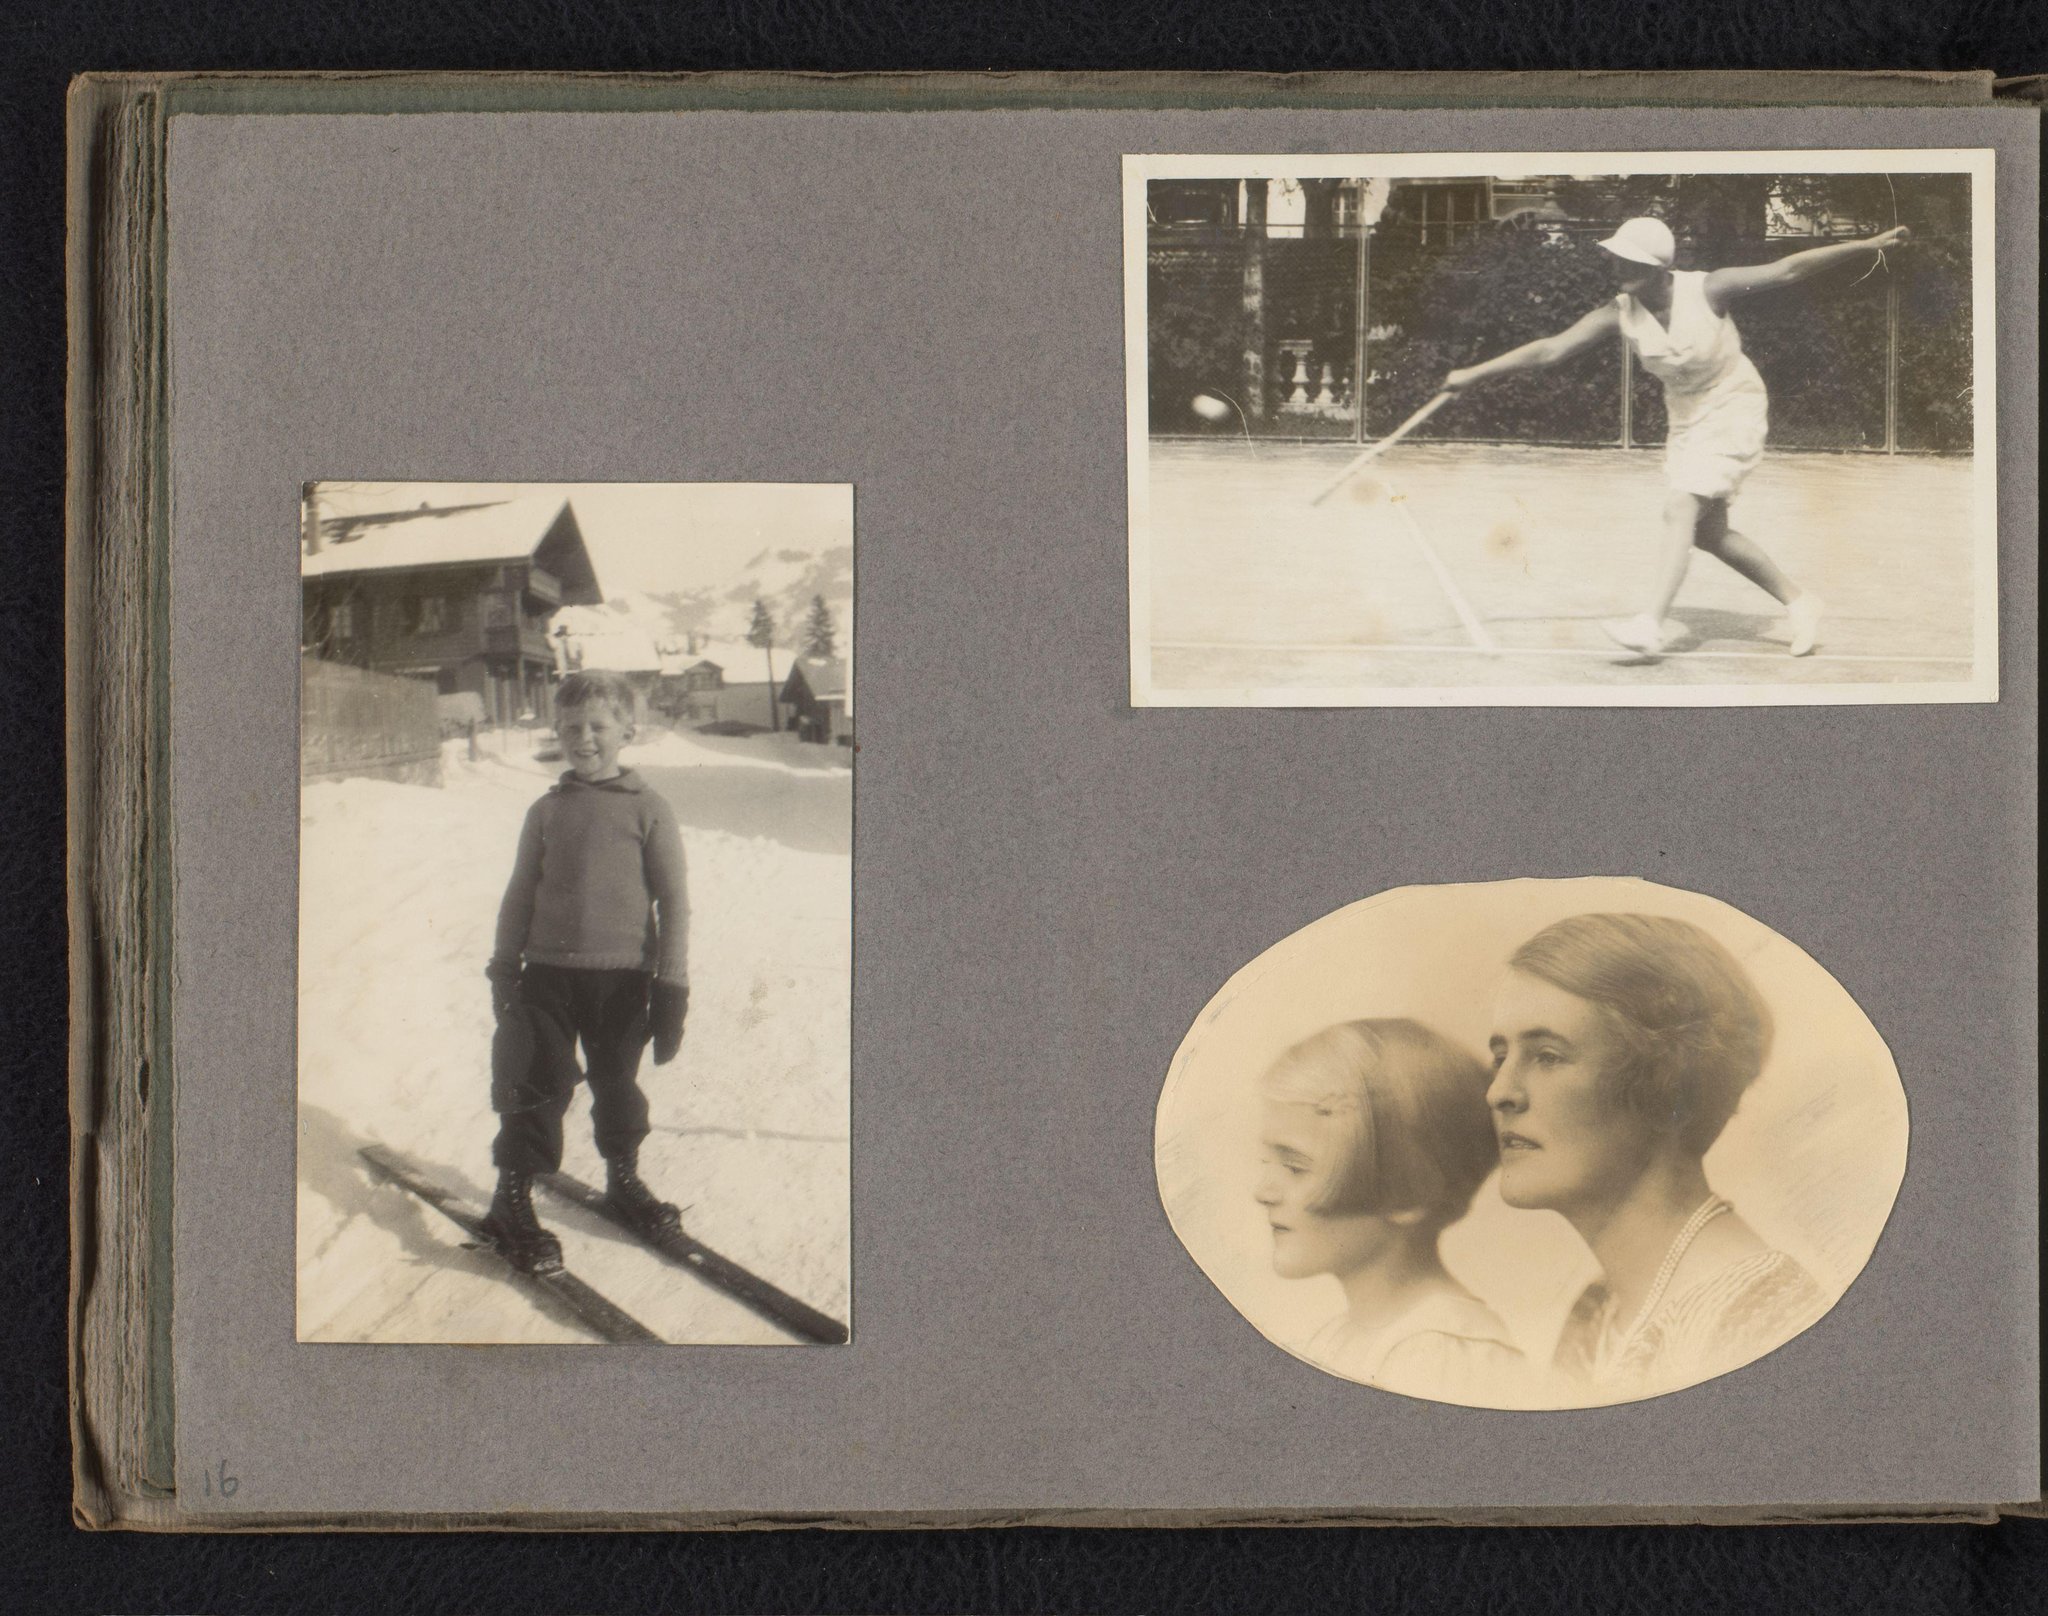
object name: photograph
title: Drie foto's van familie Onnen-Van den Berg tijdens een skivakantie, op de tennisbaan en een portret van een vrouw en dochter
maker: Anonymous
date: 1920-1930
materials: paper, cardboard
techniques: gelatin silver print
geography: europe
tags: skis (winter sports), mother with daughter(s) (mother-love), the family travelling, on holiday, tennis, lawn-tennis, historical persons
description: Deze foto's maken deel uit van een album.